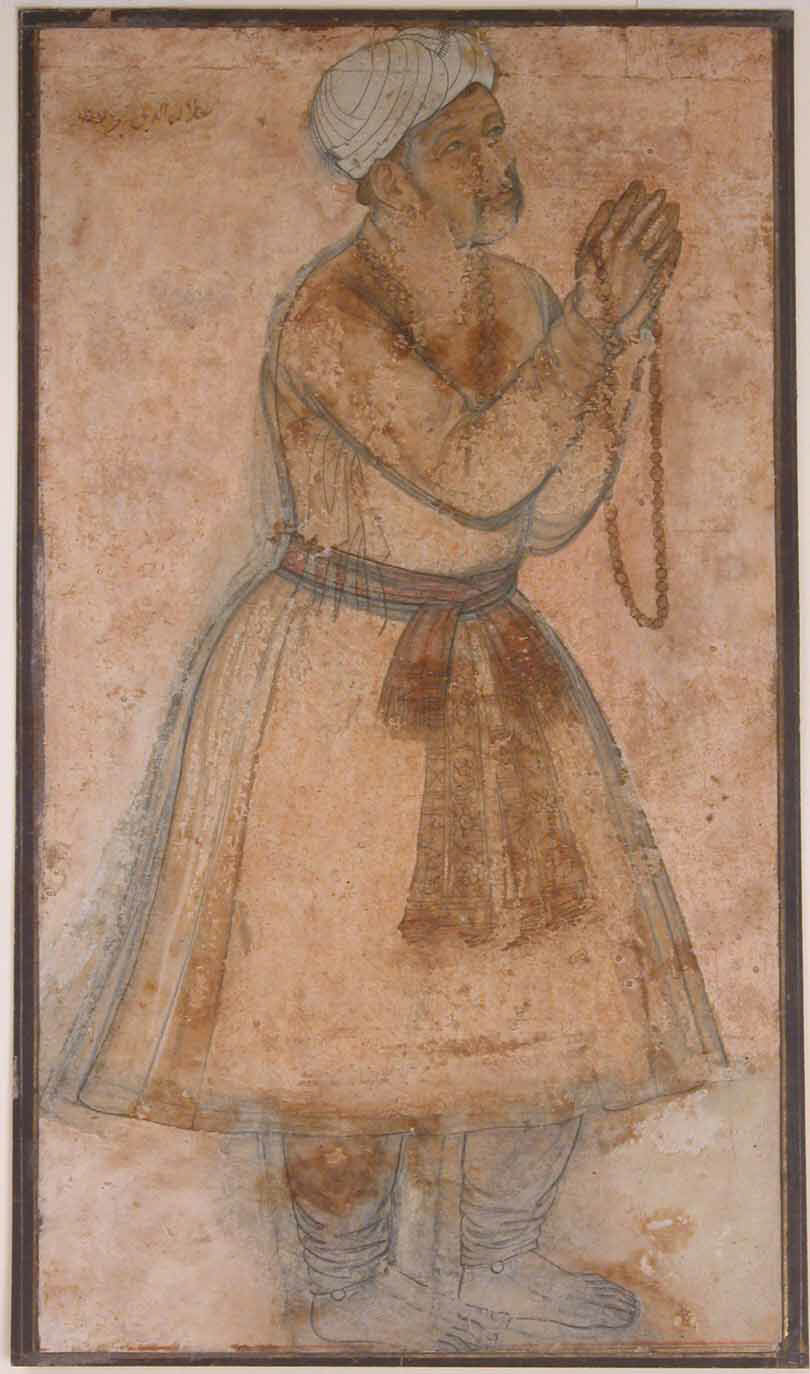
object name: illustrated single work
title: Portrait of Emperor Akbar Praying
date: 1601-1633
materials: ink, paper, watercolor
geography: india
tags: men,portraits,rosaries,praying